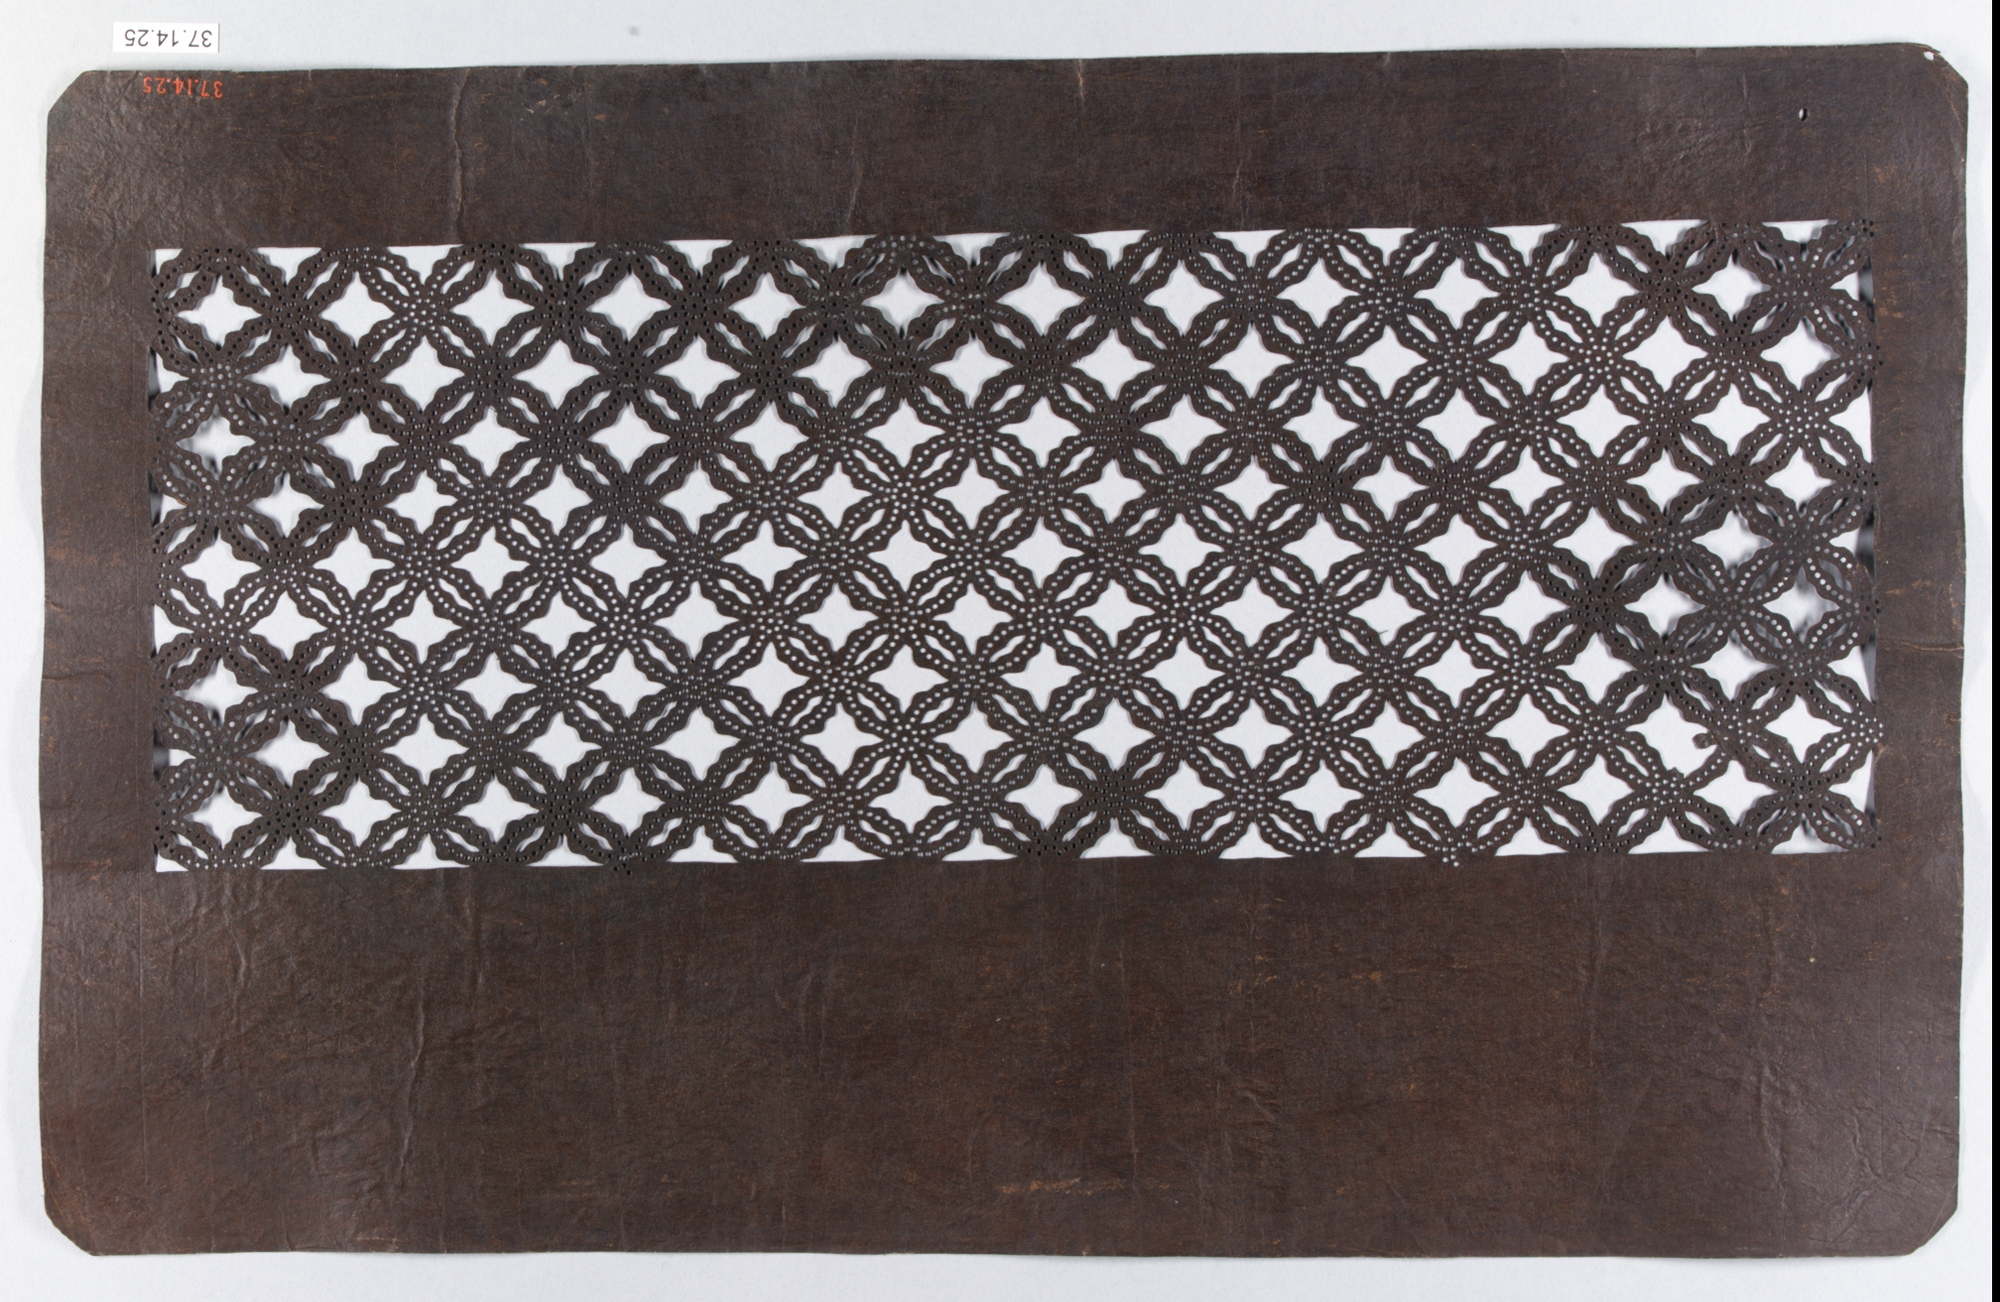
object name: stencil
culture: japanese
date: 1801-1833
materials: paper